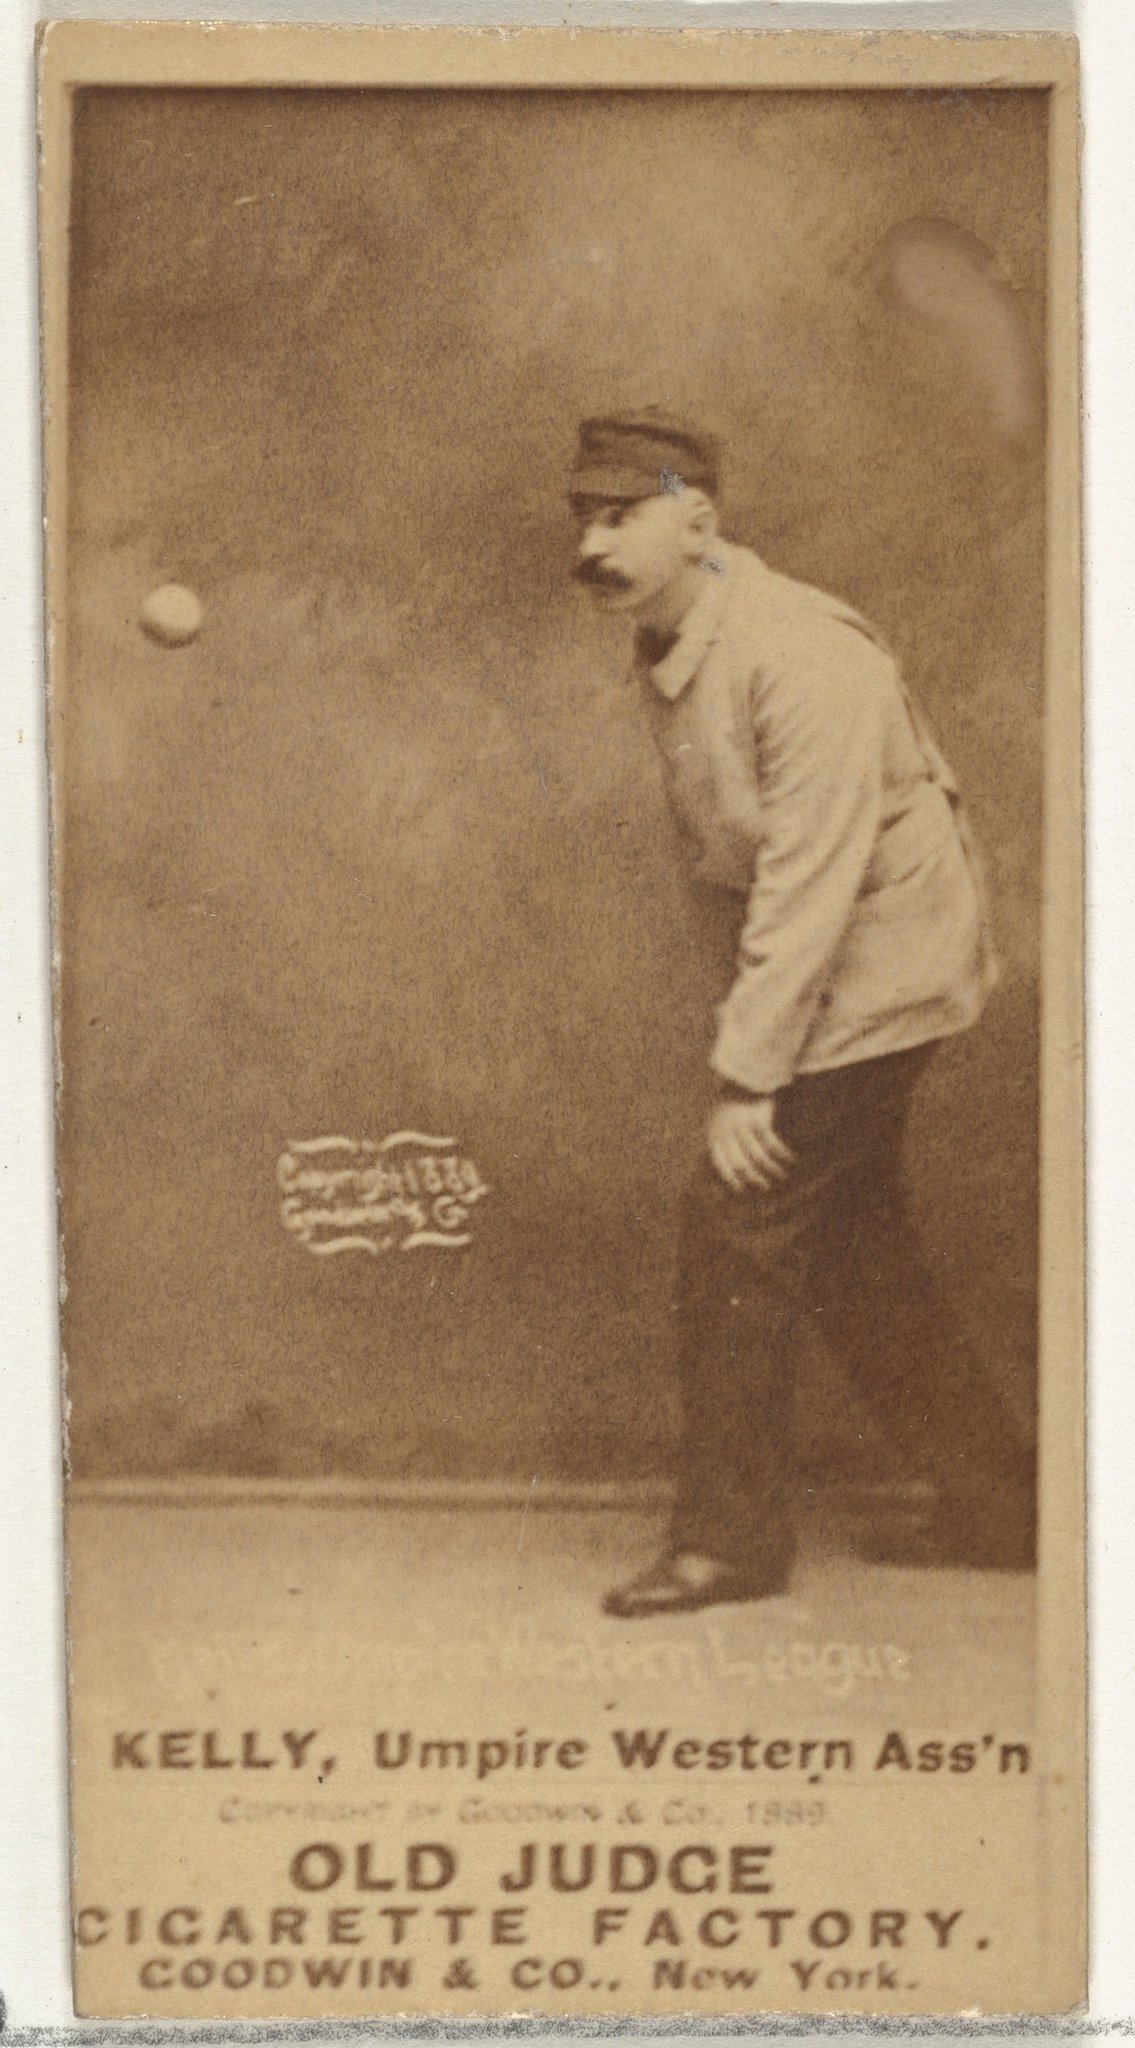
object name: baseball card, photograph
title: Kelly, Umpire, Western Association, from the Old Judge series (N172) for Old Judge Cigarettes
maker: goodwin & company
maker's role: publisher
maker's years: 1850-1950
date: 1889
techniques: albumen silver print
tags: men,portraits,baseball,athletes